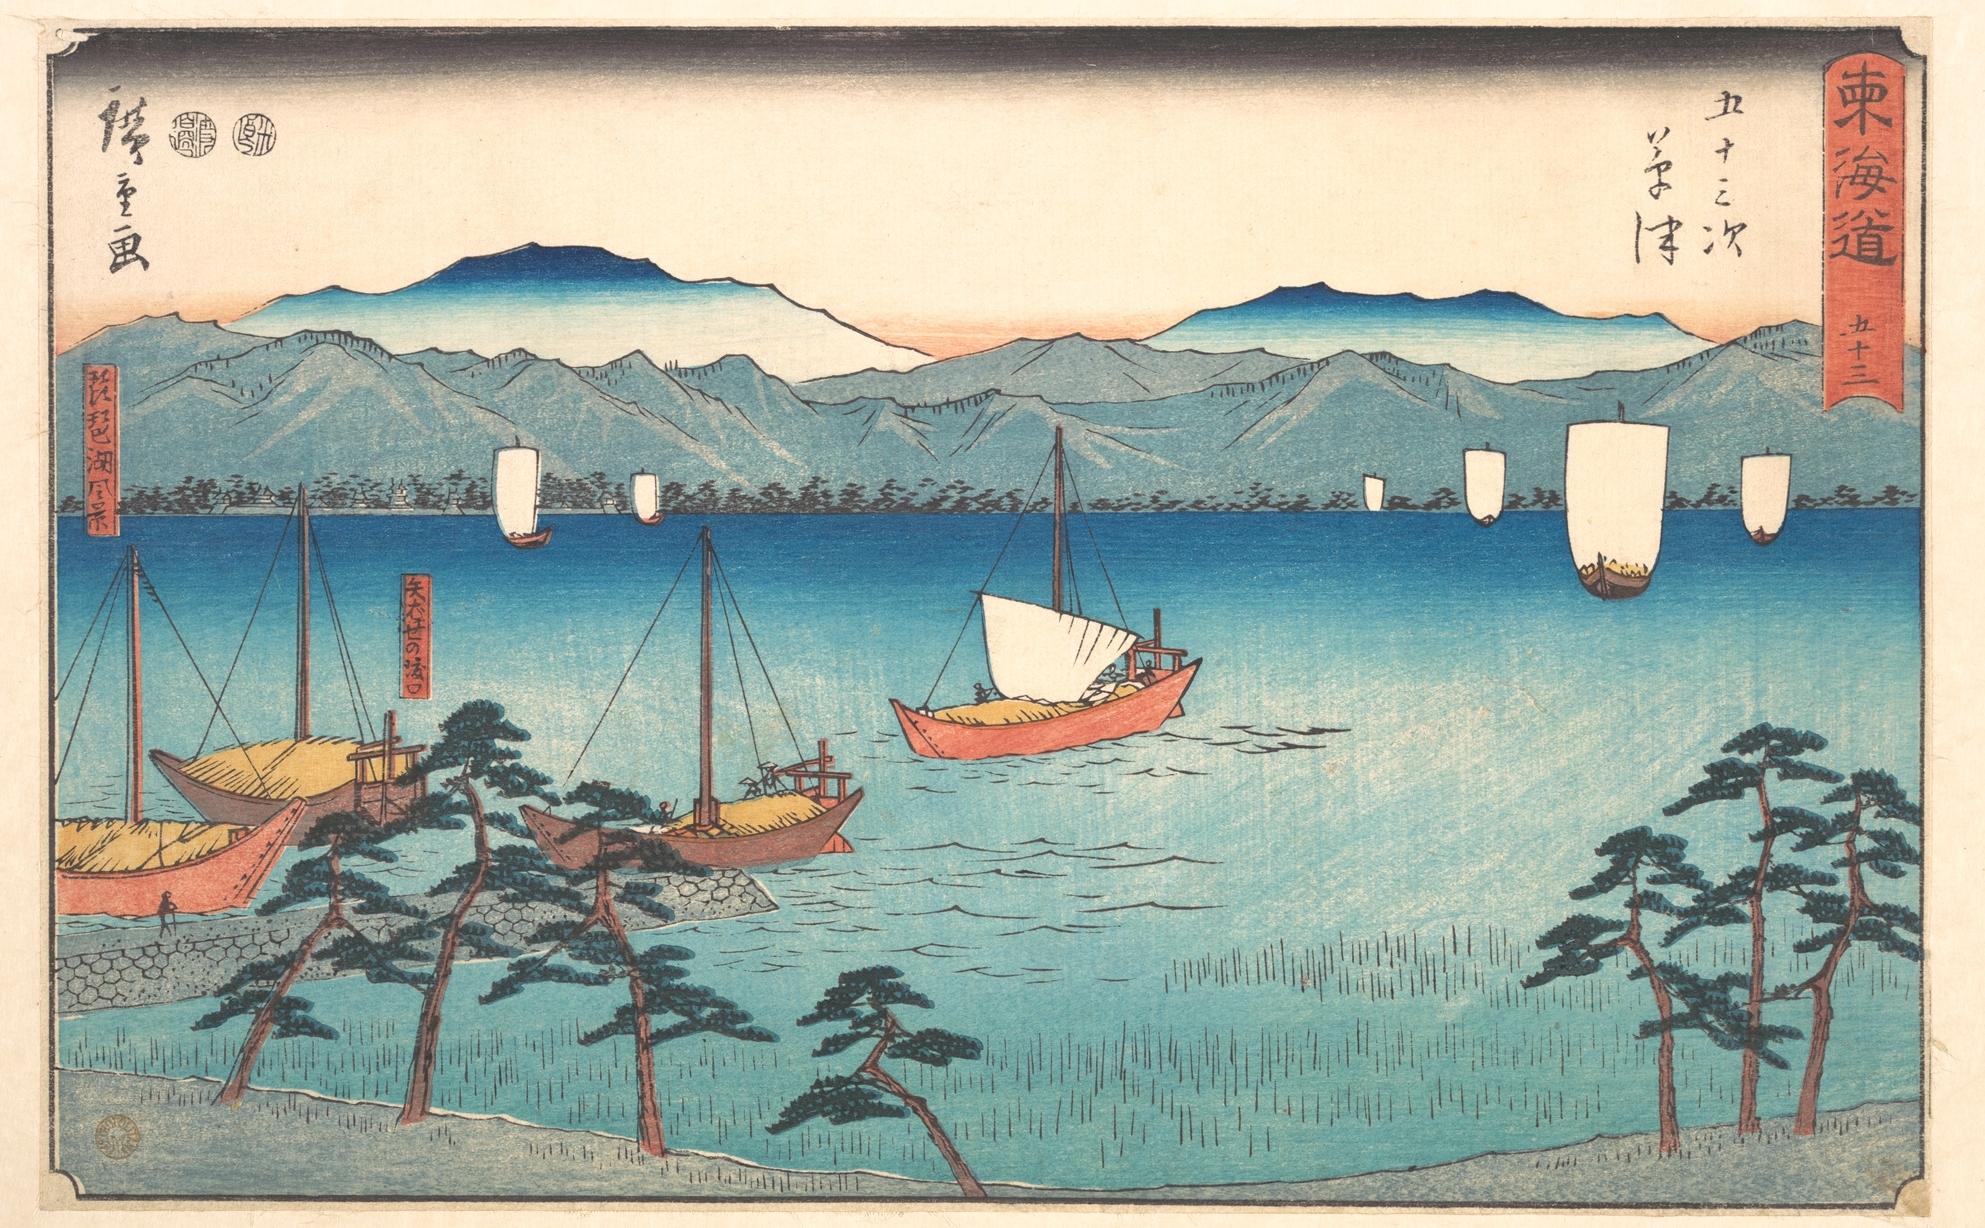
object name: print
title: Kusatsu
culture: japanese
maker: utagawa hiroshige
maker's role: artist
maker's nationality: japanese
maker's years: 1797-1858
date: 1840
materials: ink, paper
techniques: woodblock print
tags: lakes,mountains,landscapes,boats